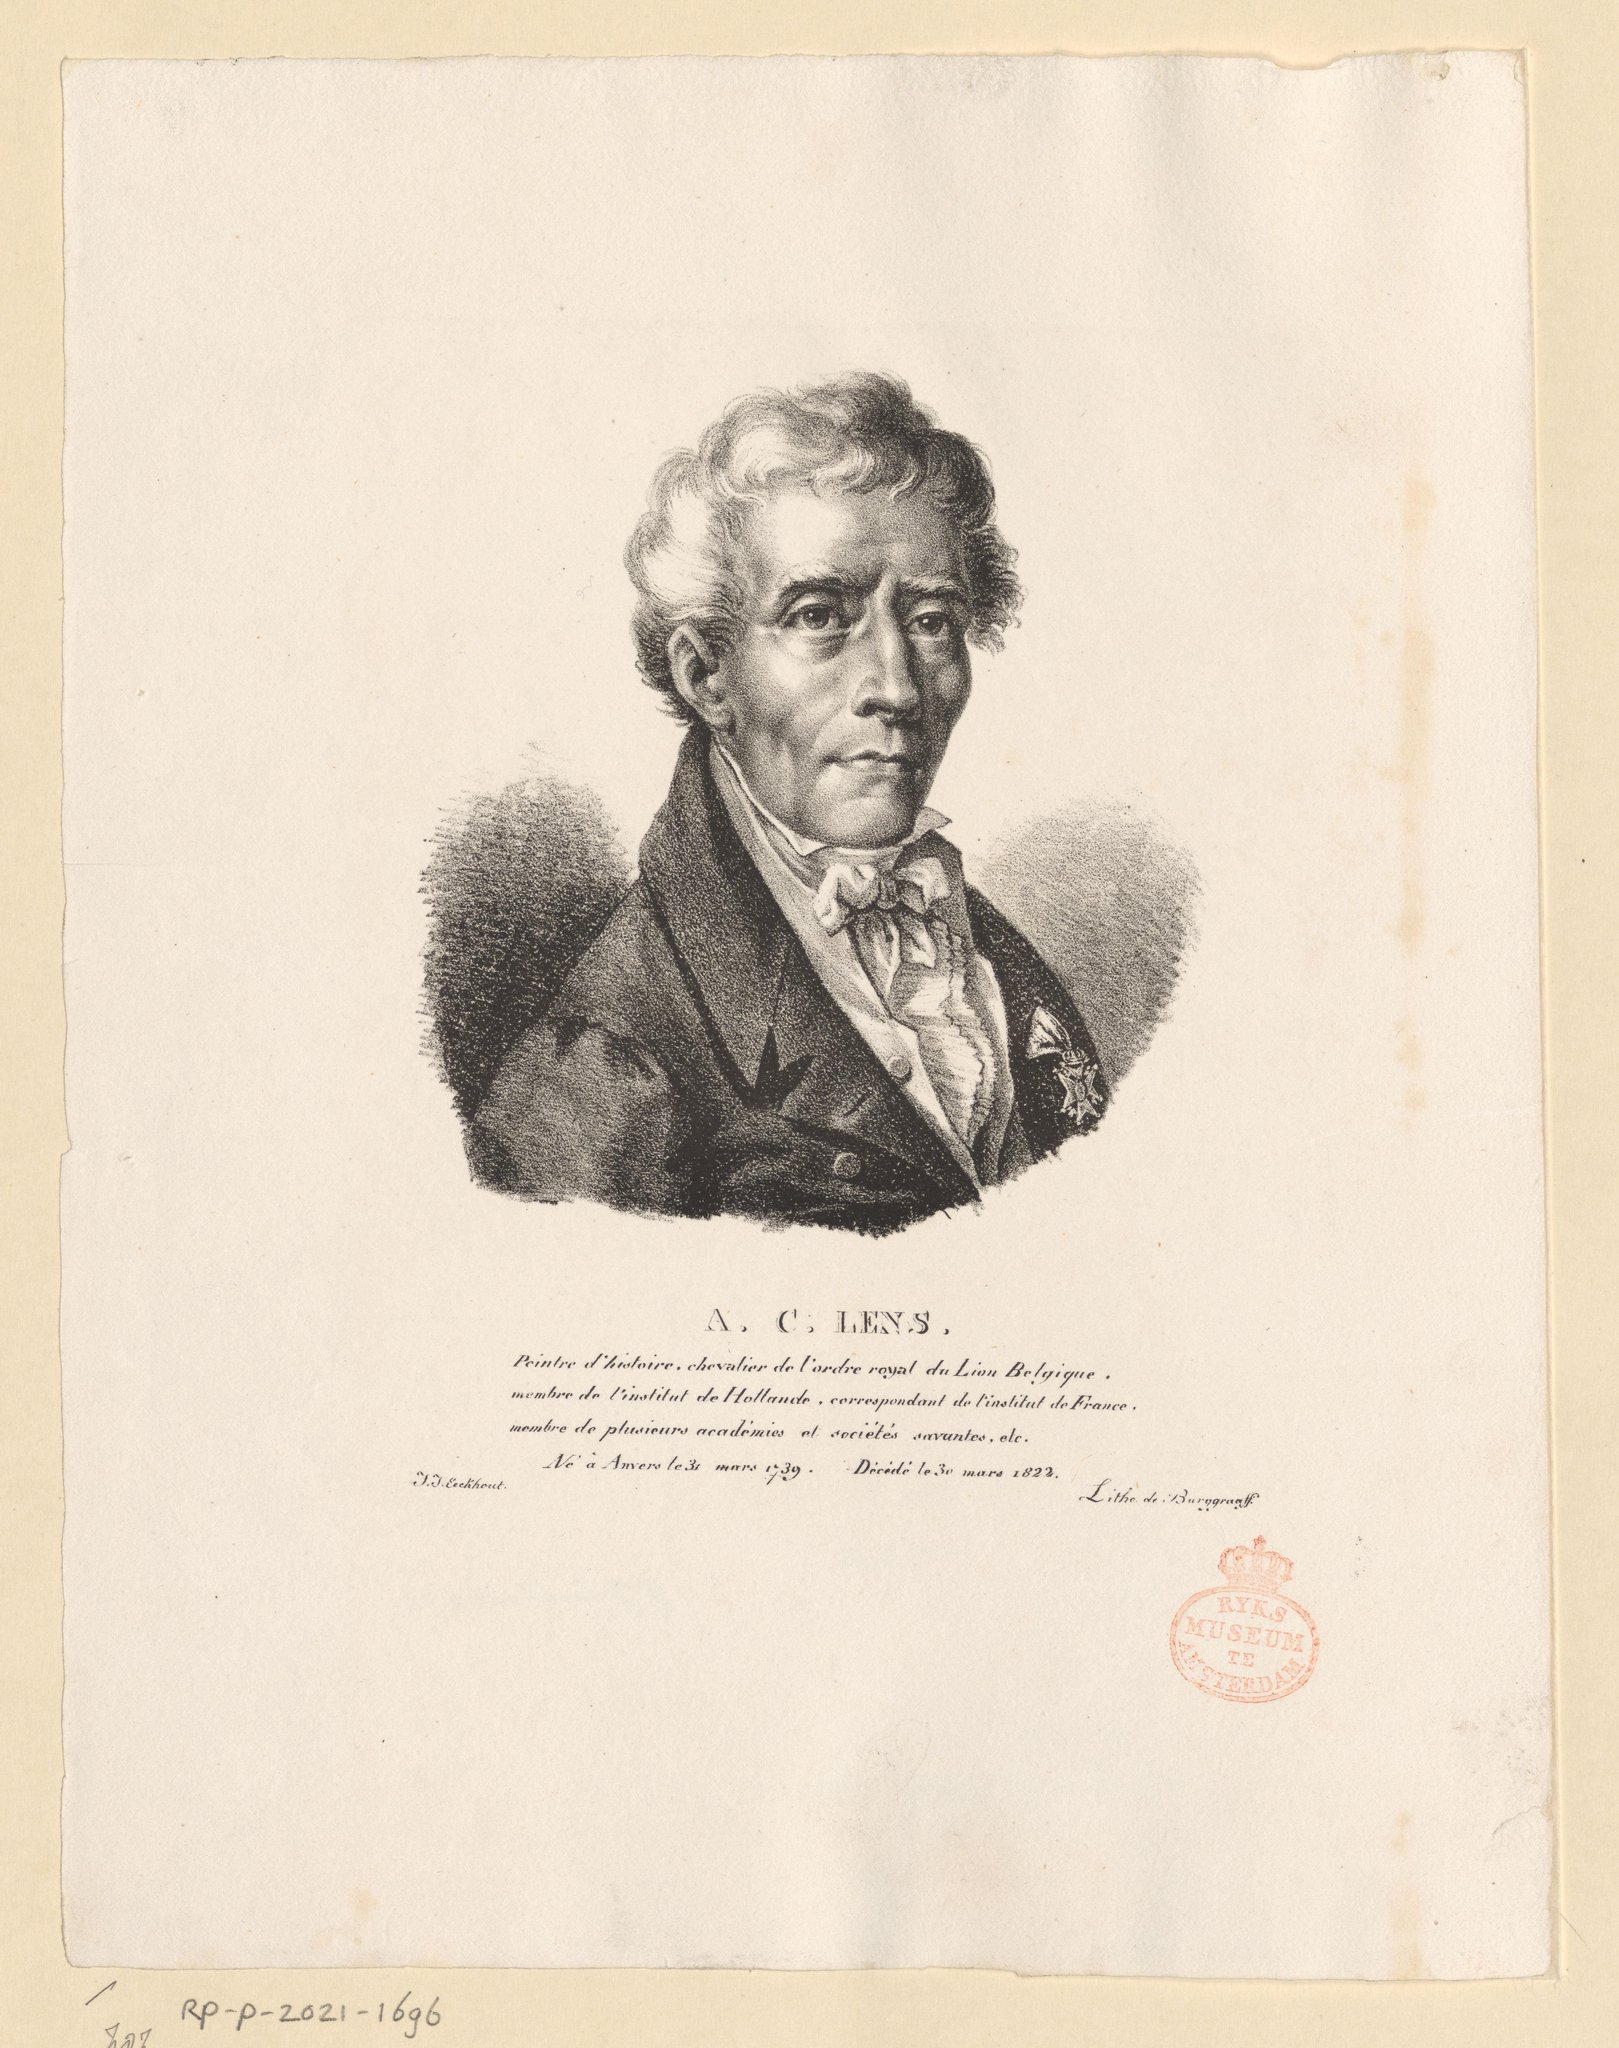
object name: print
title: Portraits des artistes modernes nés dans le Royaume des Pays-Bas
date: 1822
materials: paper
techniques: lithograph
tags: antwerp, brussels, andries lens, historical persons, portrait, self-portrait of painter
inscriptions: collector's mark: Lugt 12, collector's mark: Lugt 2228